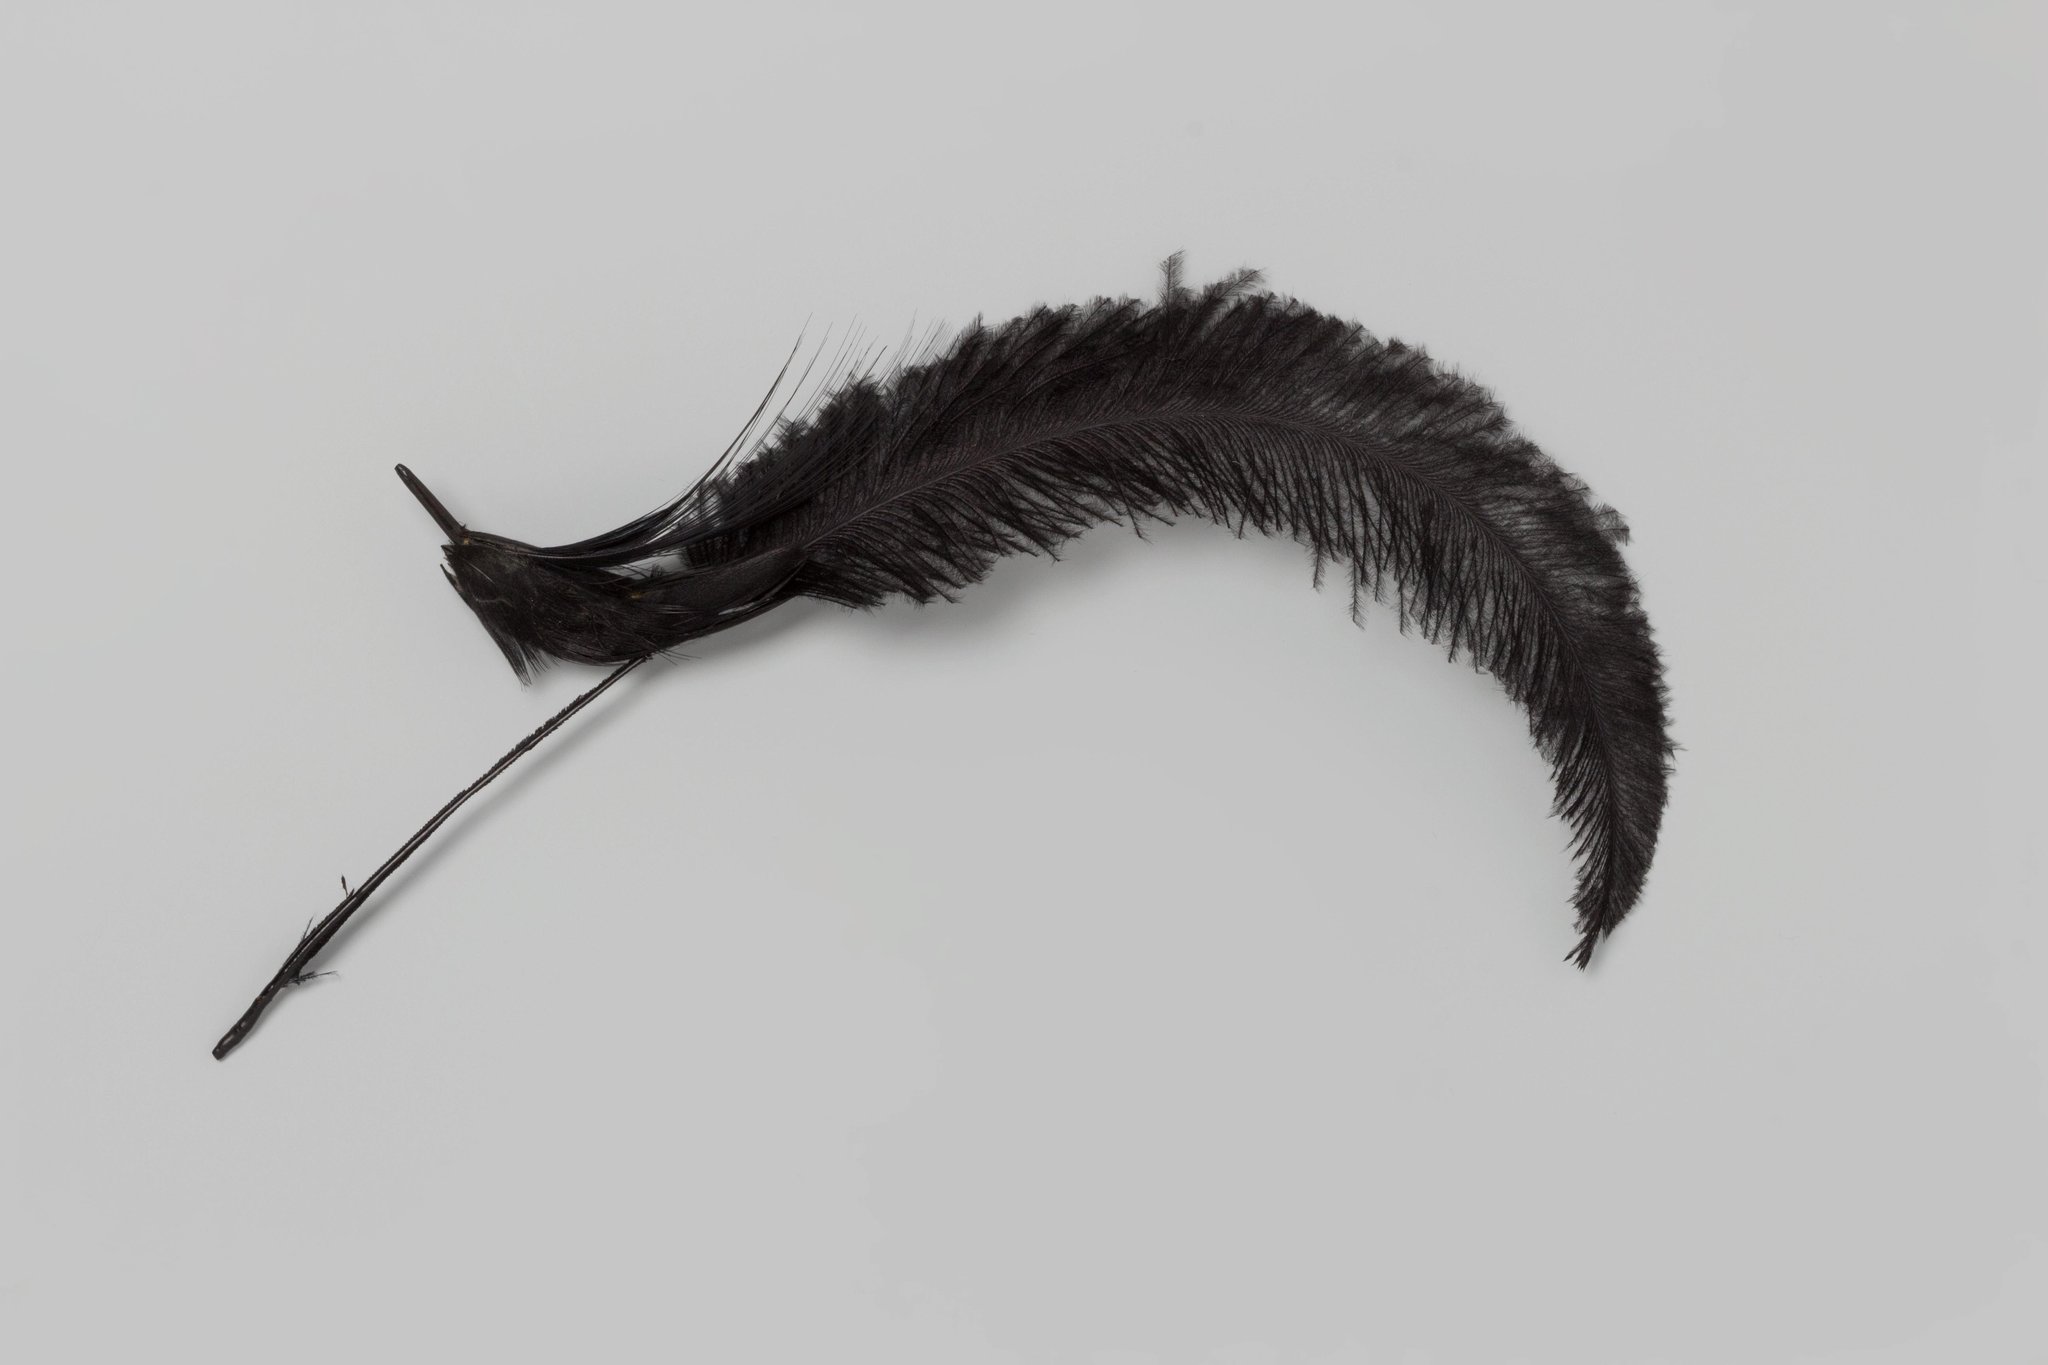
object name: hoedenveer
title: Hoedenveer in zwart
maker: Anonymous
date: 1925-1935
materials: feather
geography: netherlands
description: Hoedenveer in zwart, met afbuigende punt.